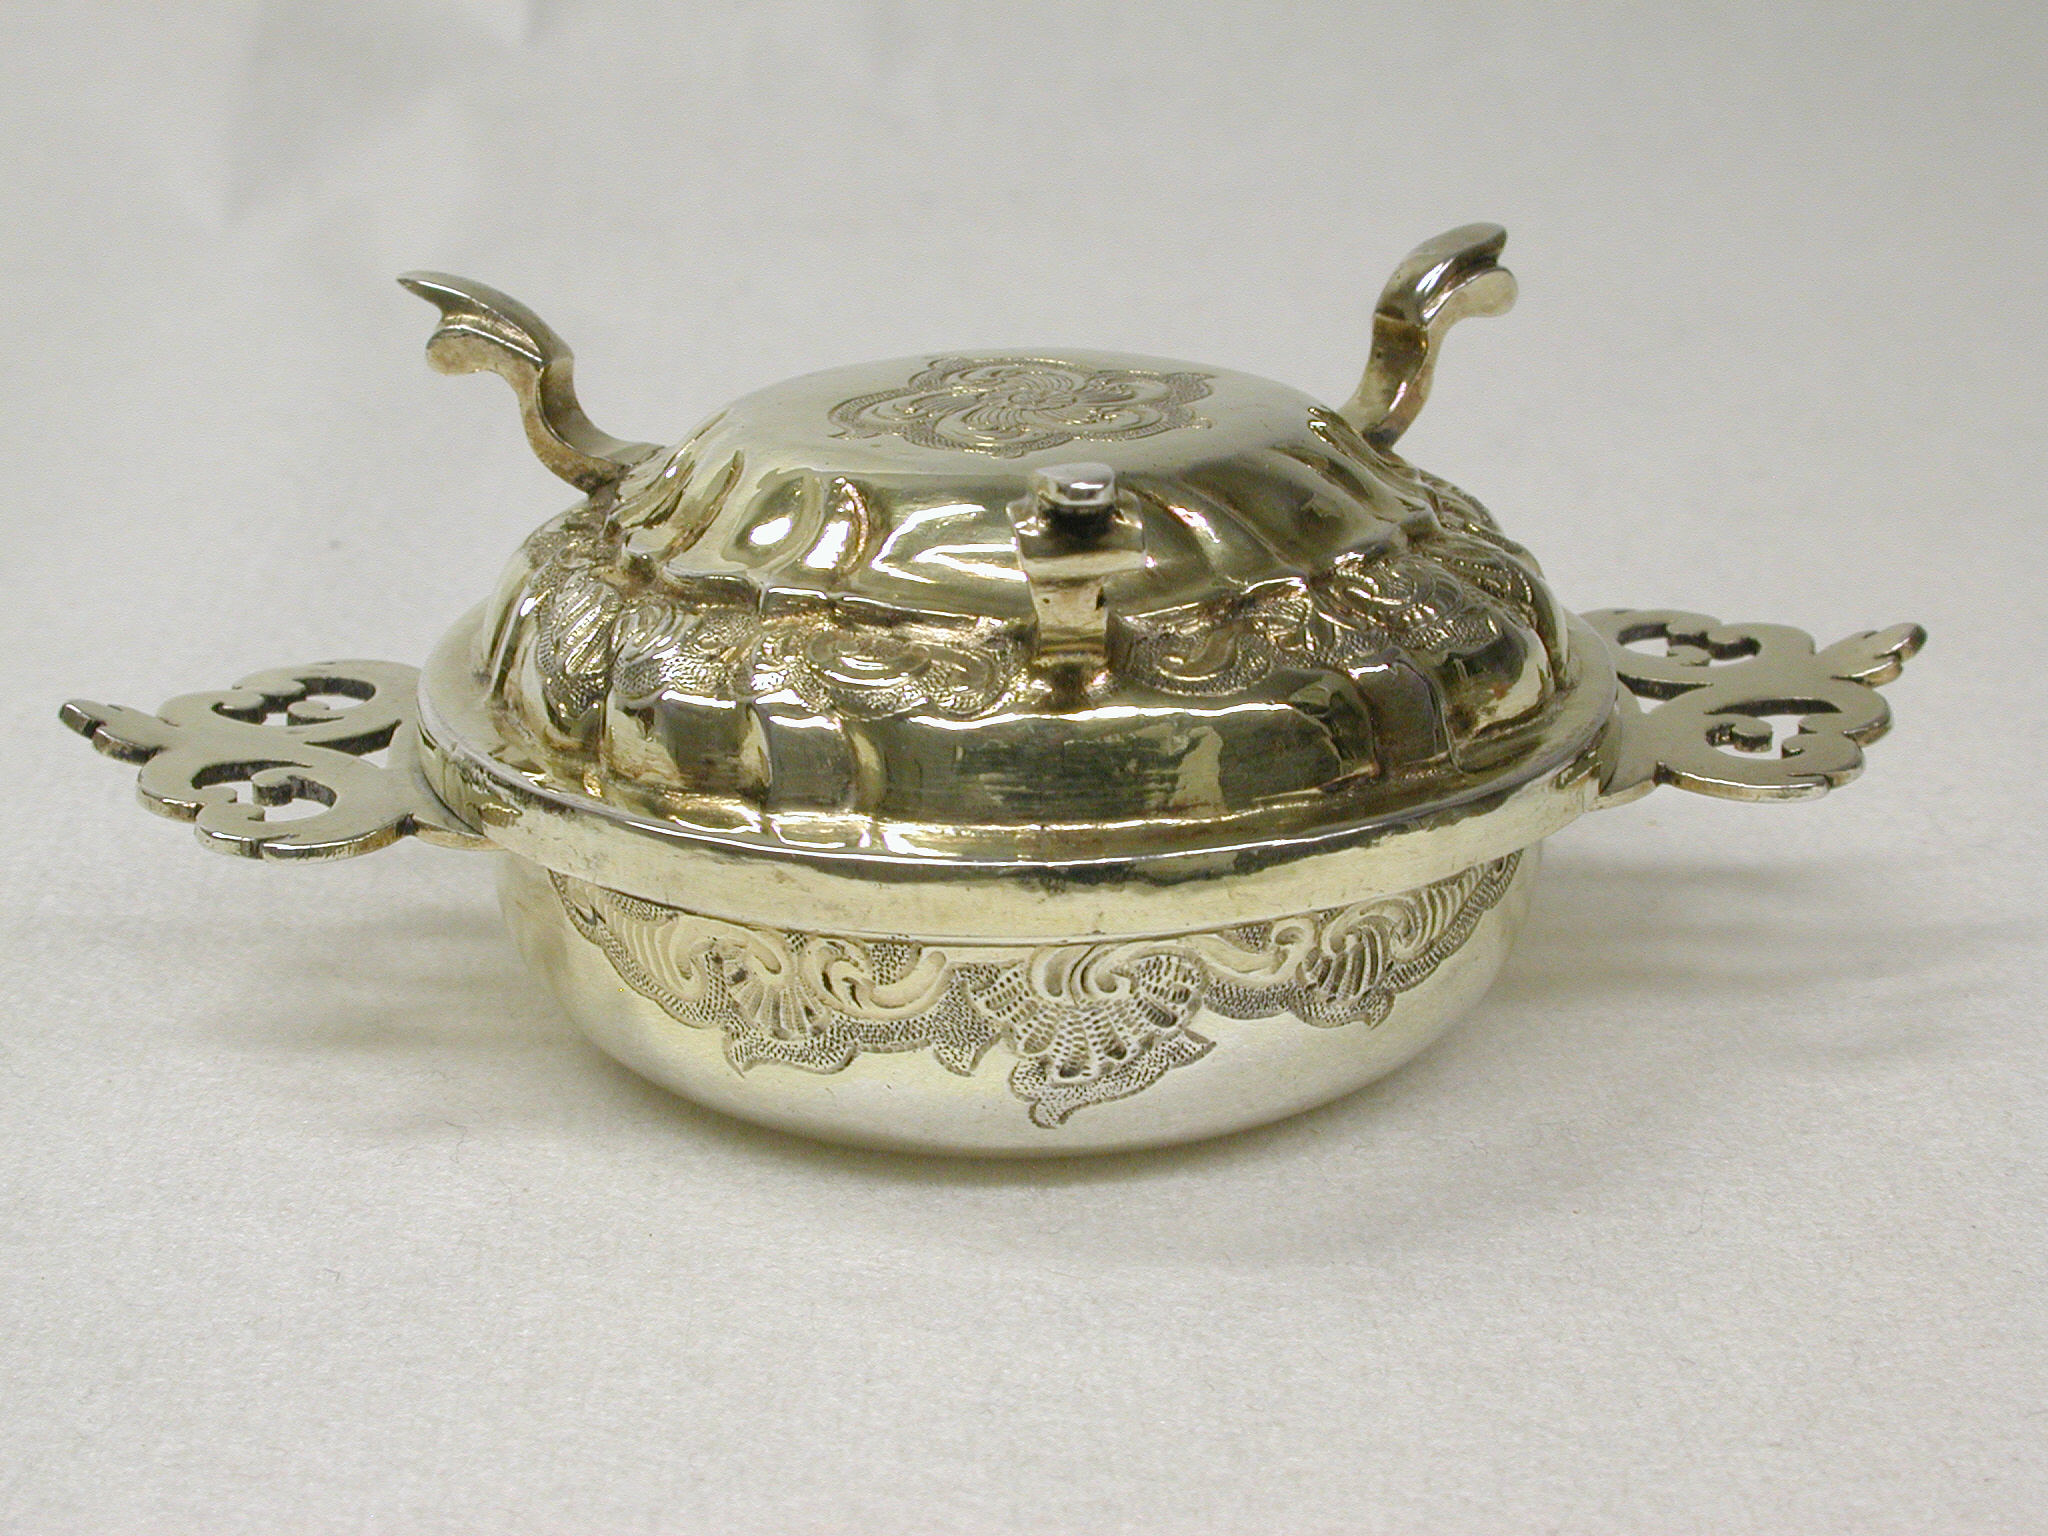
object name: écuelle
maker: johann jakob bruglocher ii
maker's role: maker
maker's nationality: german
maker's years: 1710-1752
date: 1743-1745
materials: silver gilt